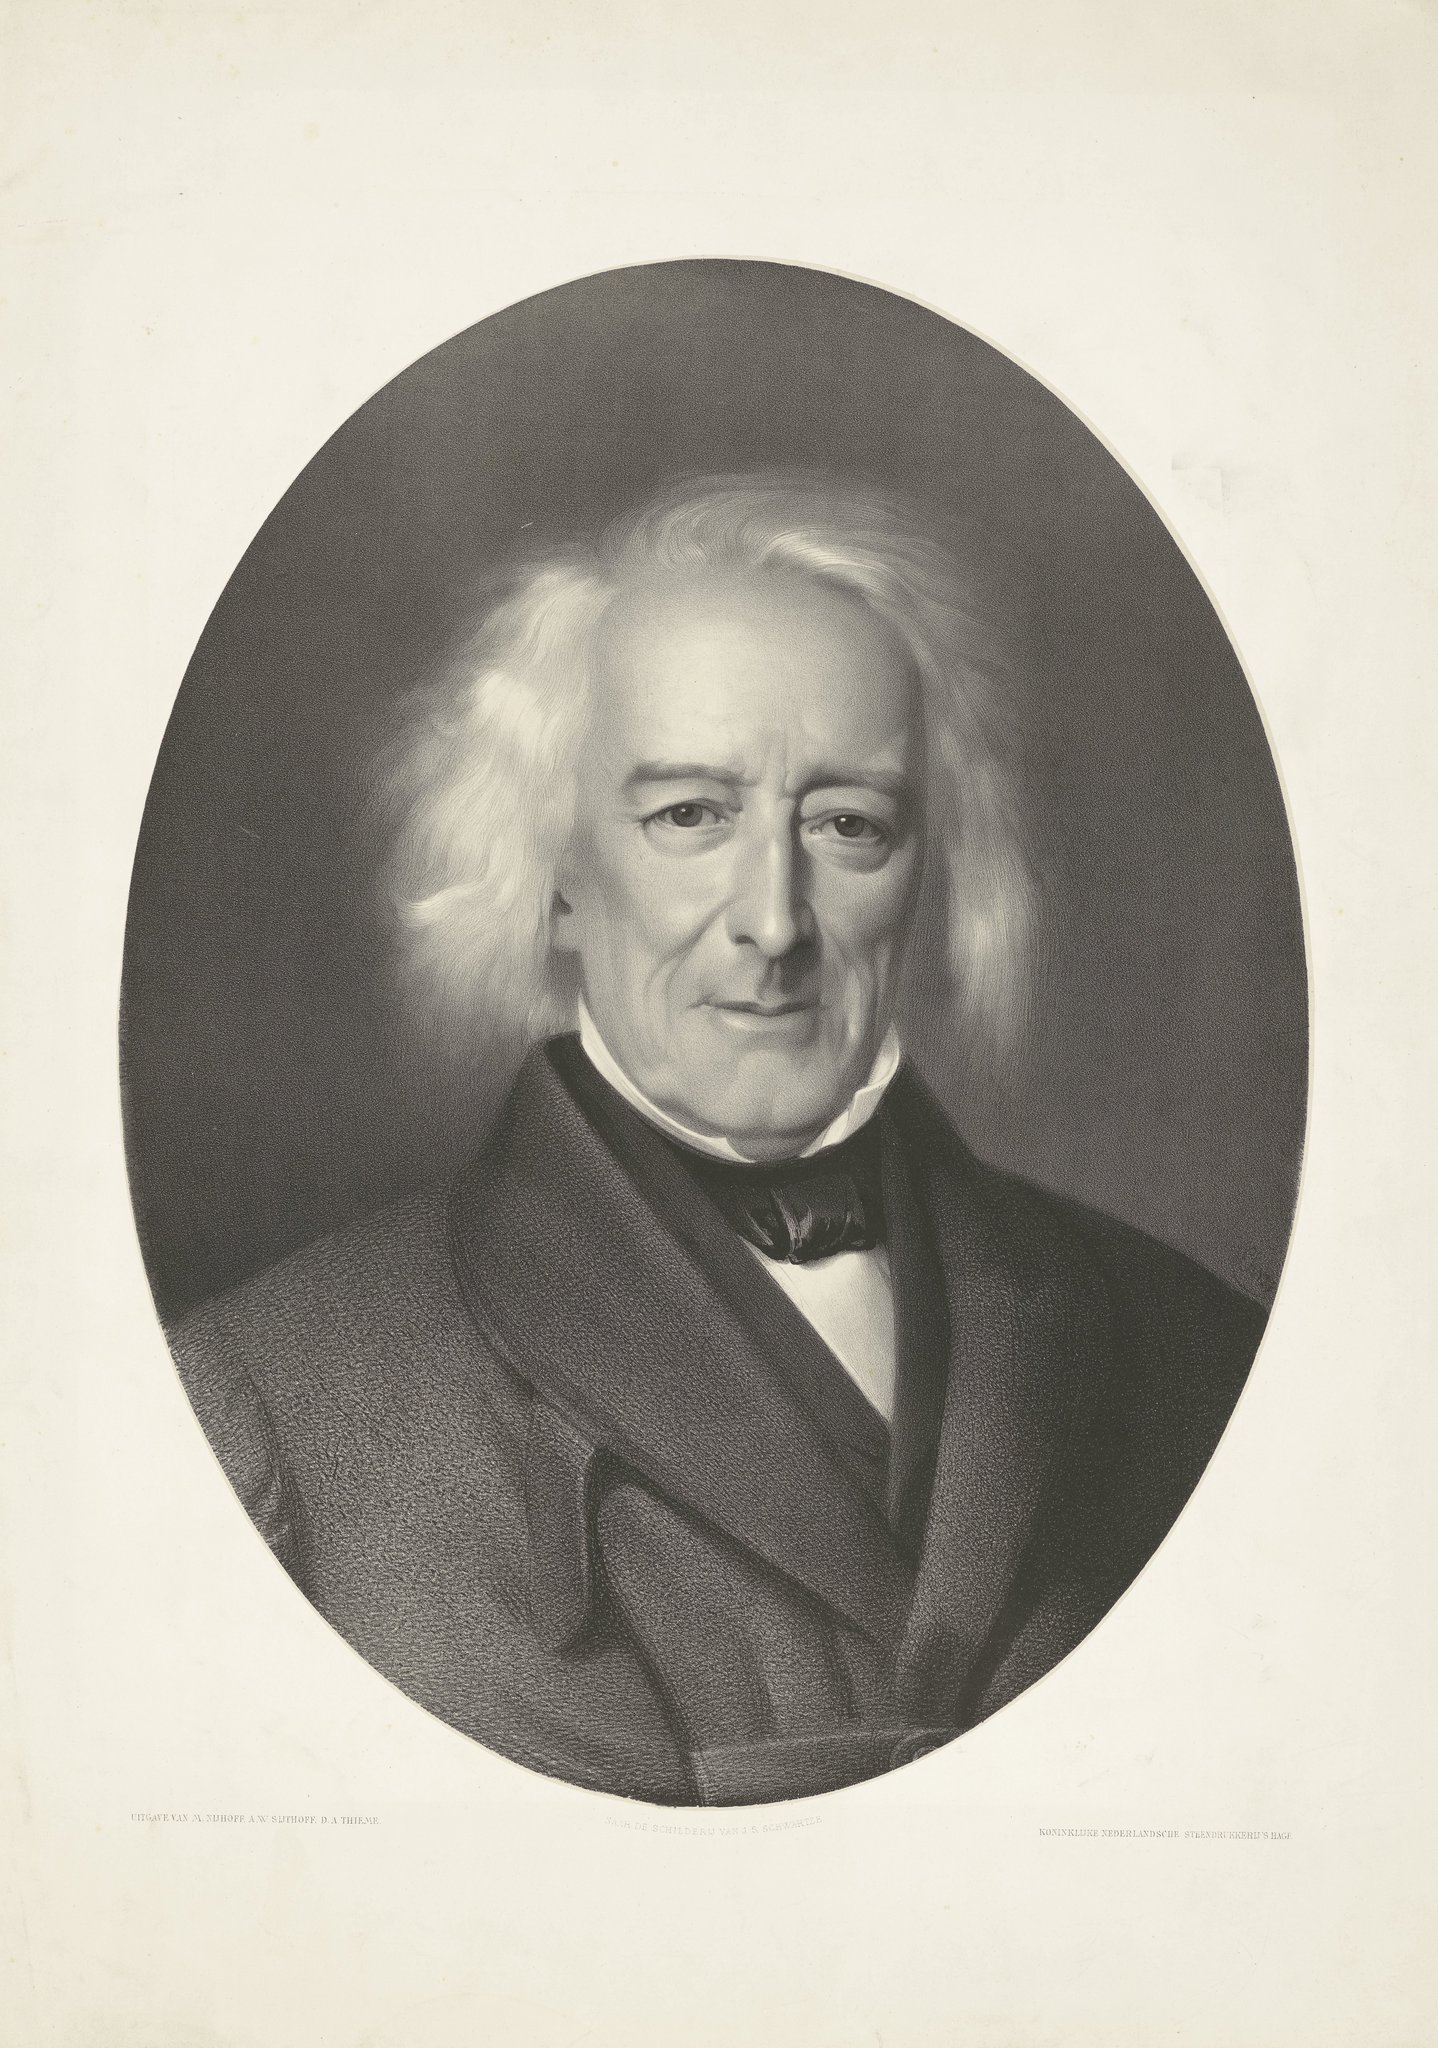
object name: print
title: Portret Jacob van Lennep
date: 1859-1873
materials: paper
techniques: lithograph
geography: the hague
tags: amsterdam, jacob van lennep, historical persons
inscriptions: collector's mark: Lugt 2228